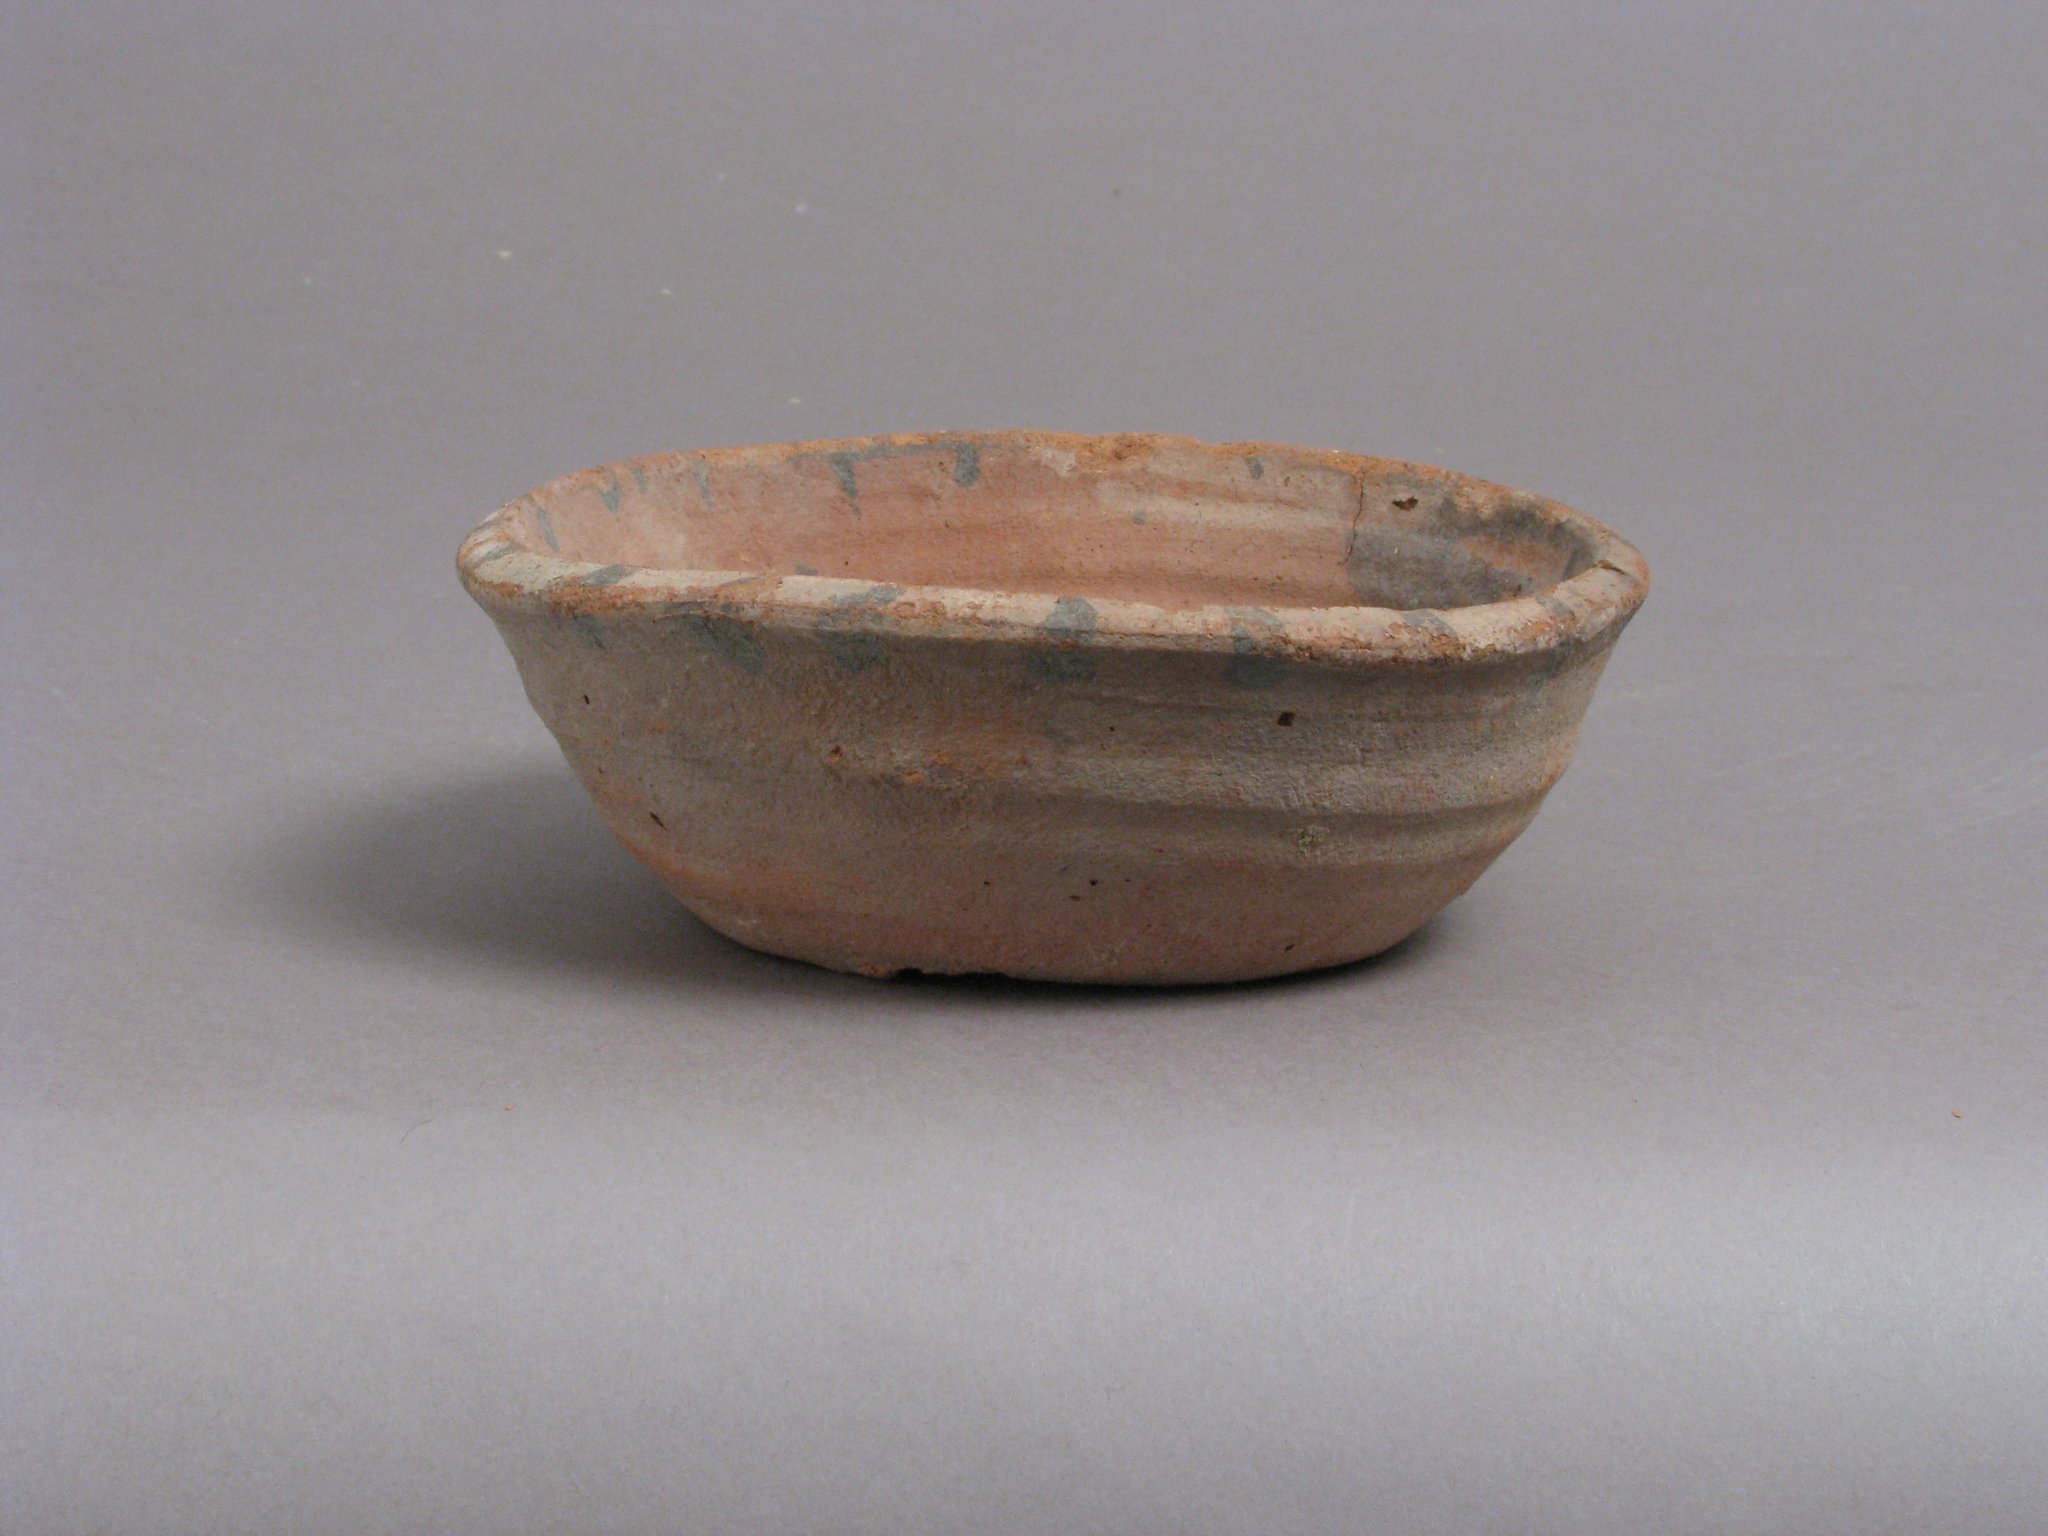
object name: bowl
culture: coptic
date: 301-700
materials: earthenware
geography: egypt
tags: bowls